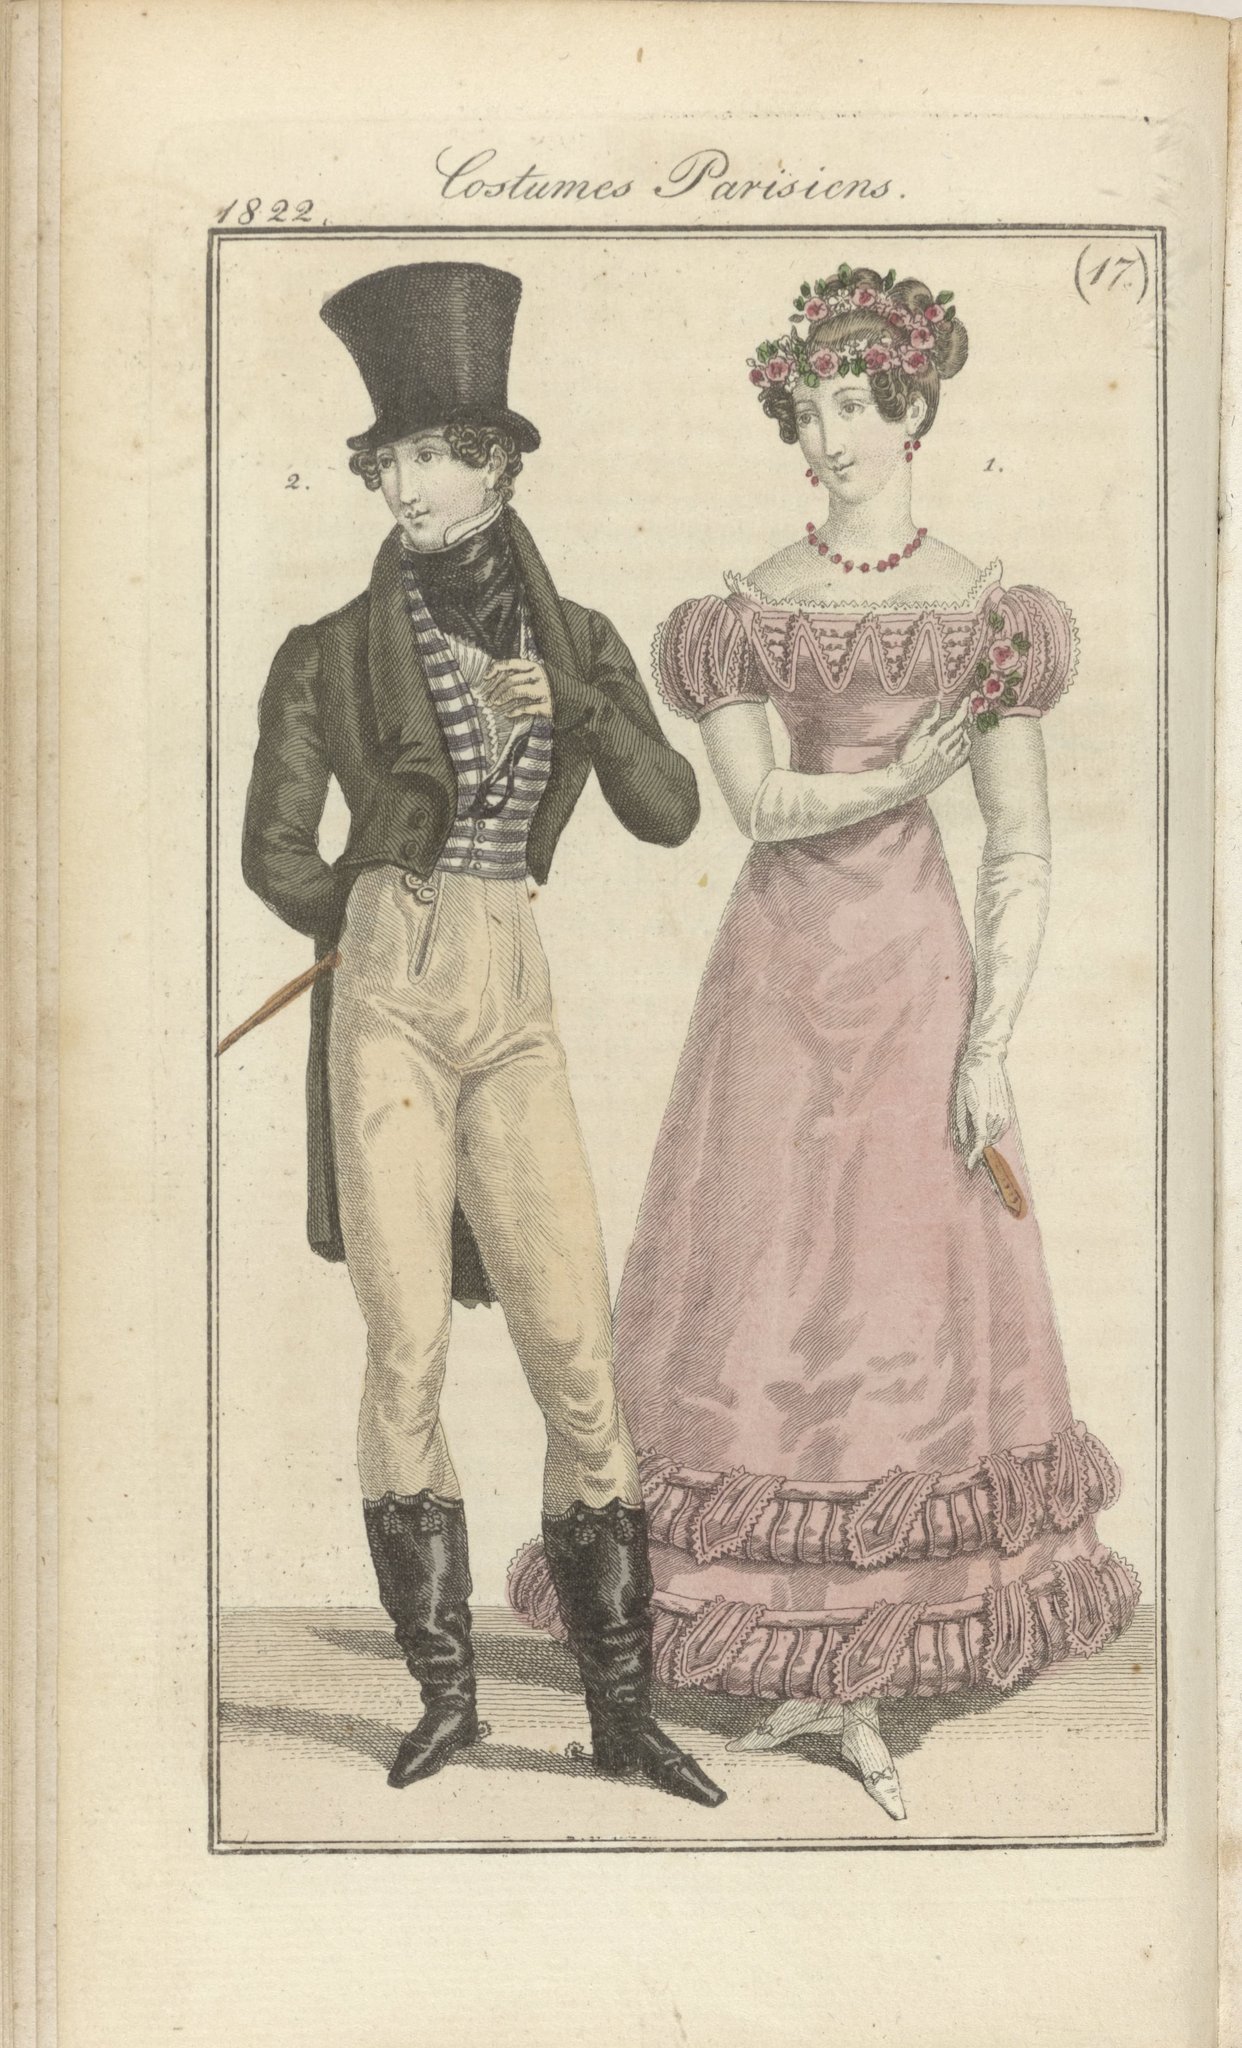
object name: fashion print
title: Journal des Dames et des Modes, editie Frankfurt 1822, 21 Avril, Costumes Parisiens (17)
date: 1822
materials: paper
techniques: engraving, hand coloring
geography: frankfurt am main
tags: clothing for the upper part of the body (vest) (+ men's clothes), gloves, mittens (long gloves) (+ women's clothes), lace (+ women's clothes), trousers, breeches, etc. (pantalon) (+ men's clothes), bride (in wedding-dress) (+ variant), coat (+ men's clothes), styles of hairdress - aa - ~ women, fashion plates, shoes, sandals (+ women's clothes), dress, gown (+ women's clothes), spur, flowers: rose, boots (+ men's clothes)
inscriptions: date: ‘1822’, title: ‘Costumes Parisiens (17)’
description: Volgens de begeleidende tekst (p. 463 en 464): Fig. 1: Kostuum van een bruid voor de dag na de bruiloft. Kapsel versierd met rozen en myrthe. Japon van 'étoffe de Lyon' met garneringen van crêpe en Blonde (kloskant). Witte handschoenen en witte schoenen. Fig. 2: 'Toilette de Lonchamp'. Hoge hoed met zeer smalle rand. Cravate van gros de Naples. Vest van geitenwol en bronskleurige jas. Lange broek van hertenleer. Soepele laarzen met sporen. De prent maakt deel uit van het modetijdschrift Journal des Dames et des Modes, uitgegeven in Frankfurt als kopie van de Franse editie van Pierre de la Mésangère, Parijs, 1797-1839. Vrouw gekopieerd naar Costume Parisien 2058.